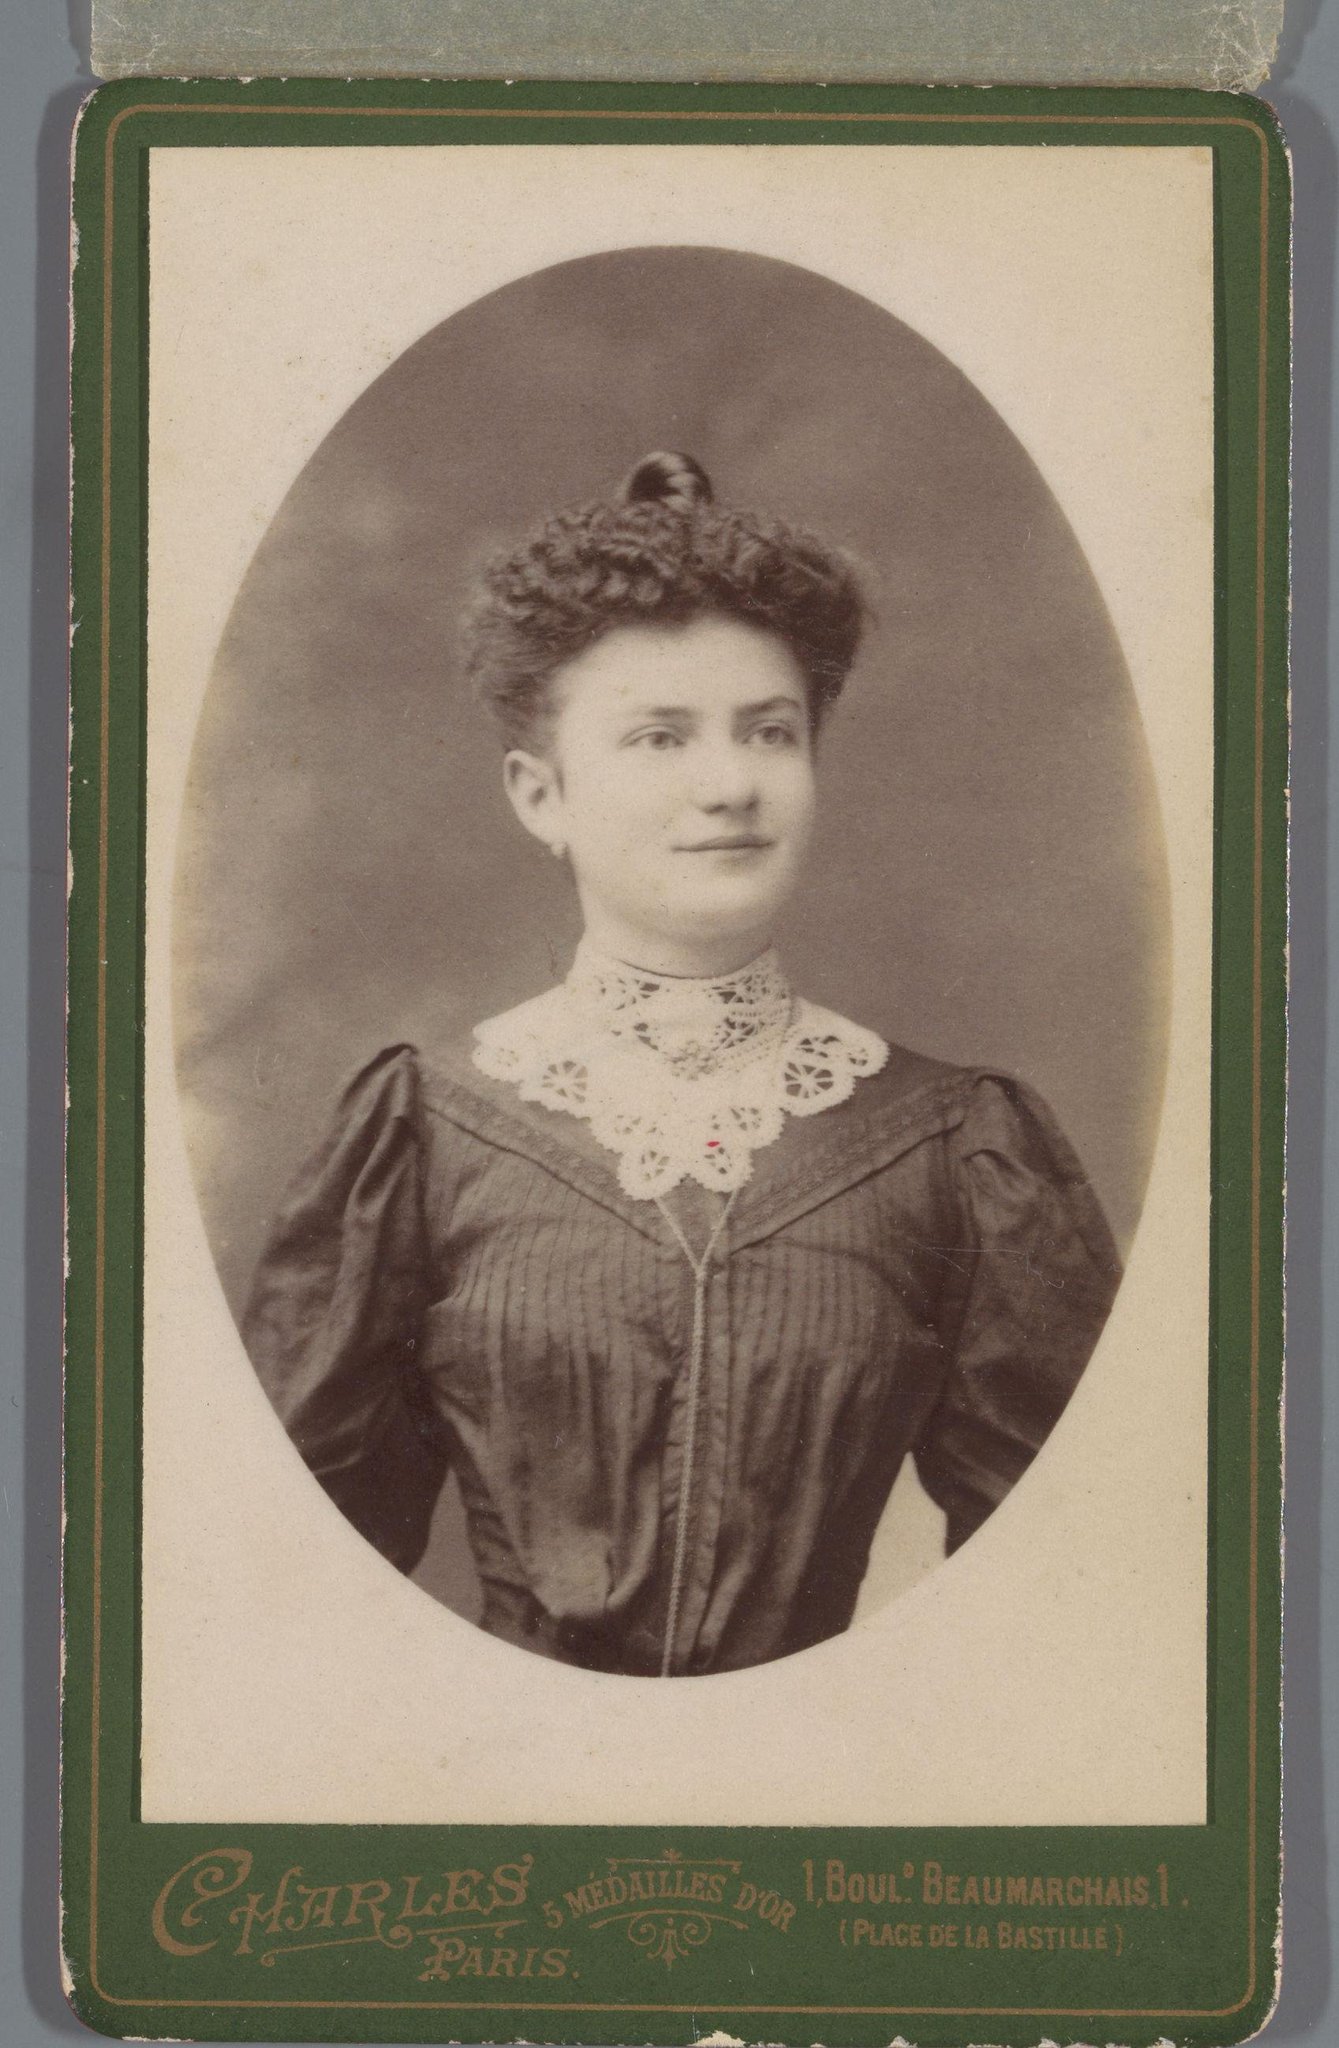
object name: carte de visite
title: Portret van een onbekende jonge vrouw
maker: charles gallot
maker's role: fotograaf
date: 1907-1914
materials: cardboard, paper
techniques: albumen print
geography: paris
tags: adolescent, young woman, maiden, anonymous historical person portrayed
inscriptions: inscription: ‘Médailles/ Paris. Lyon. Bordeaux./ Anvers. Rouen./ 37me Annee 1907/ B. P. GRIMAUD-PARIS.’, address: ‘1, Boul. Beaumarchais, 1./ (Place de la Bastille)’